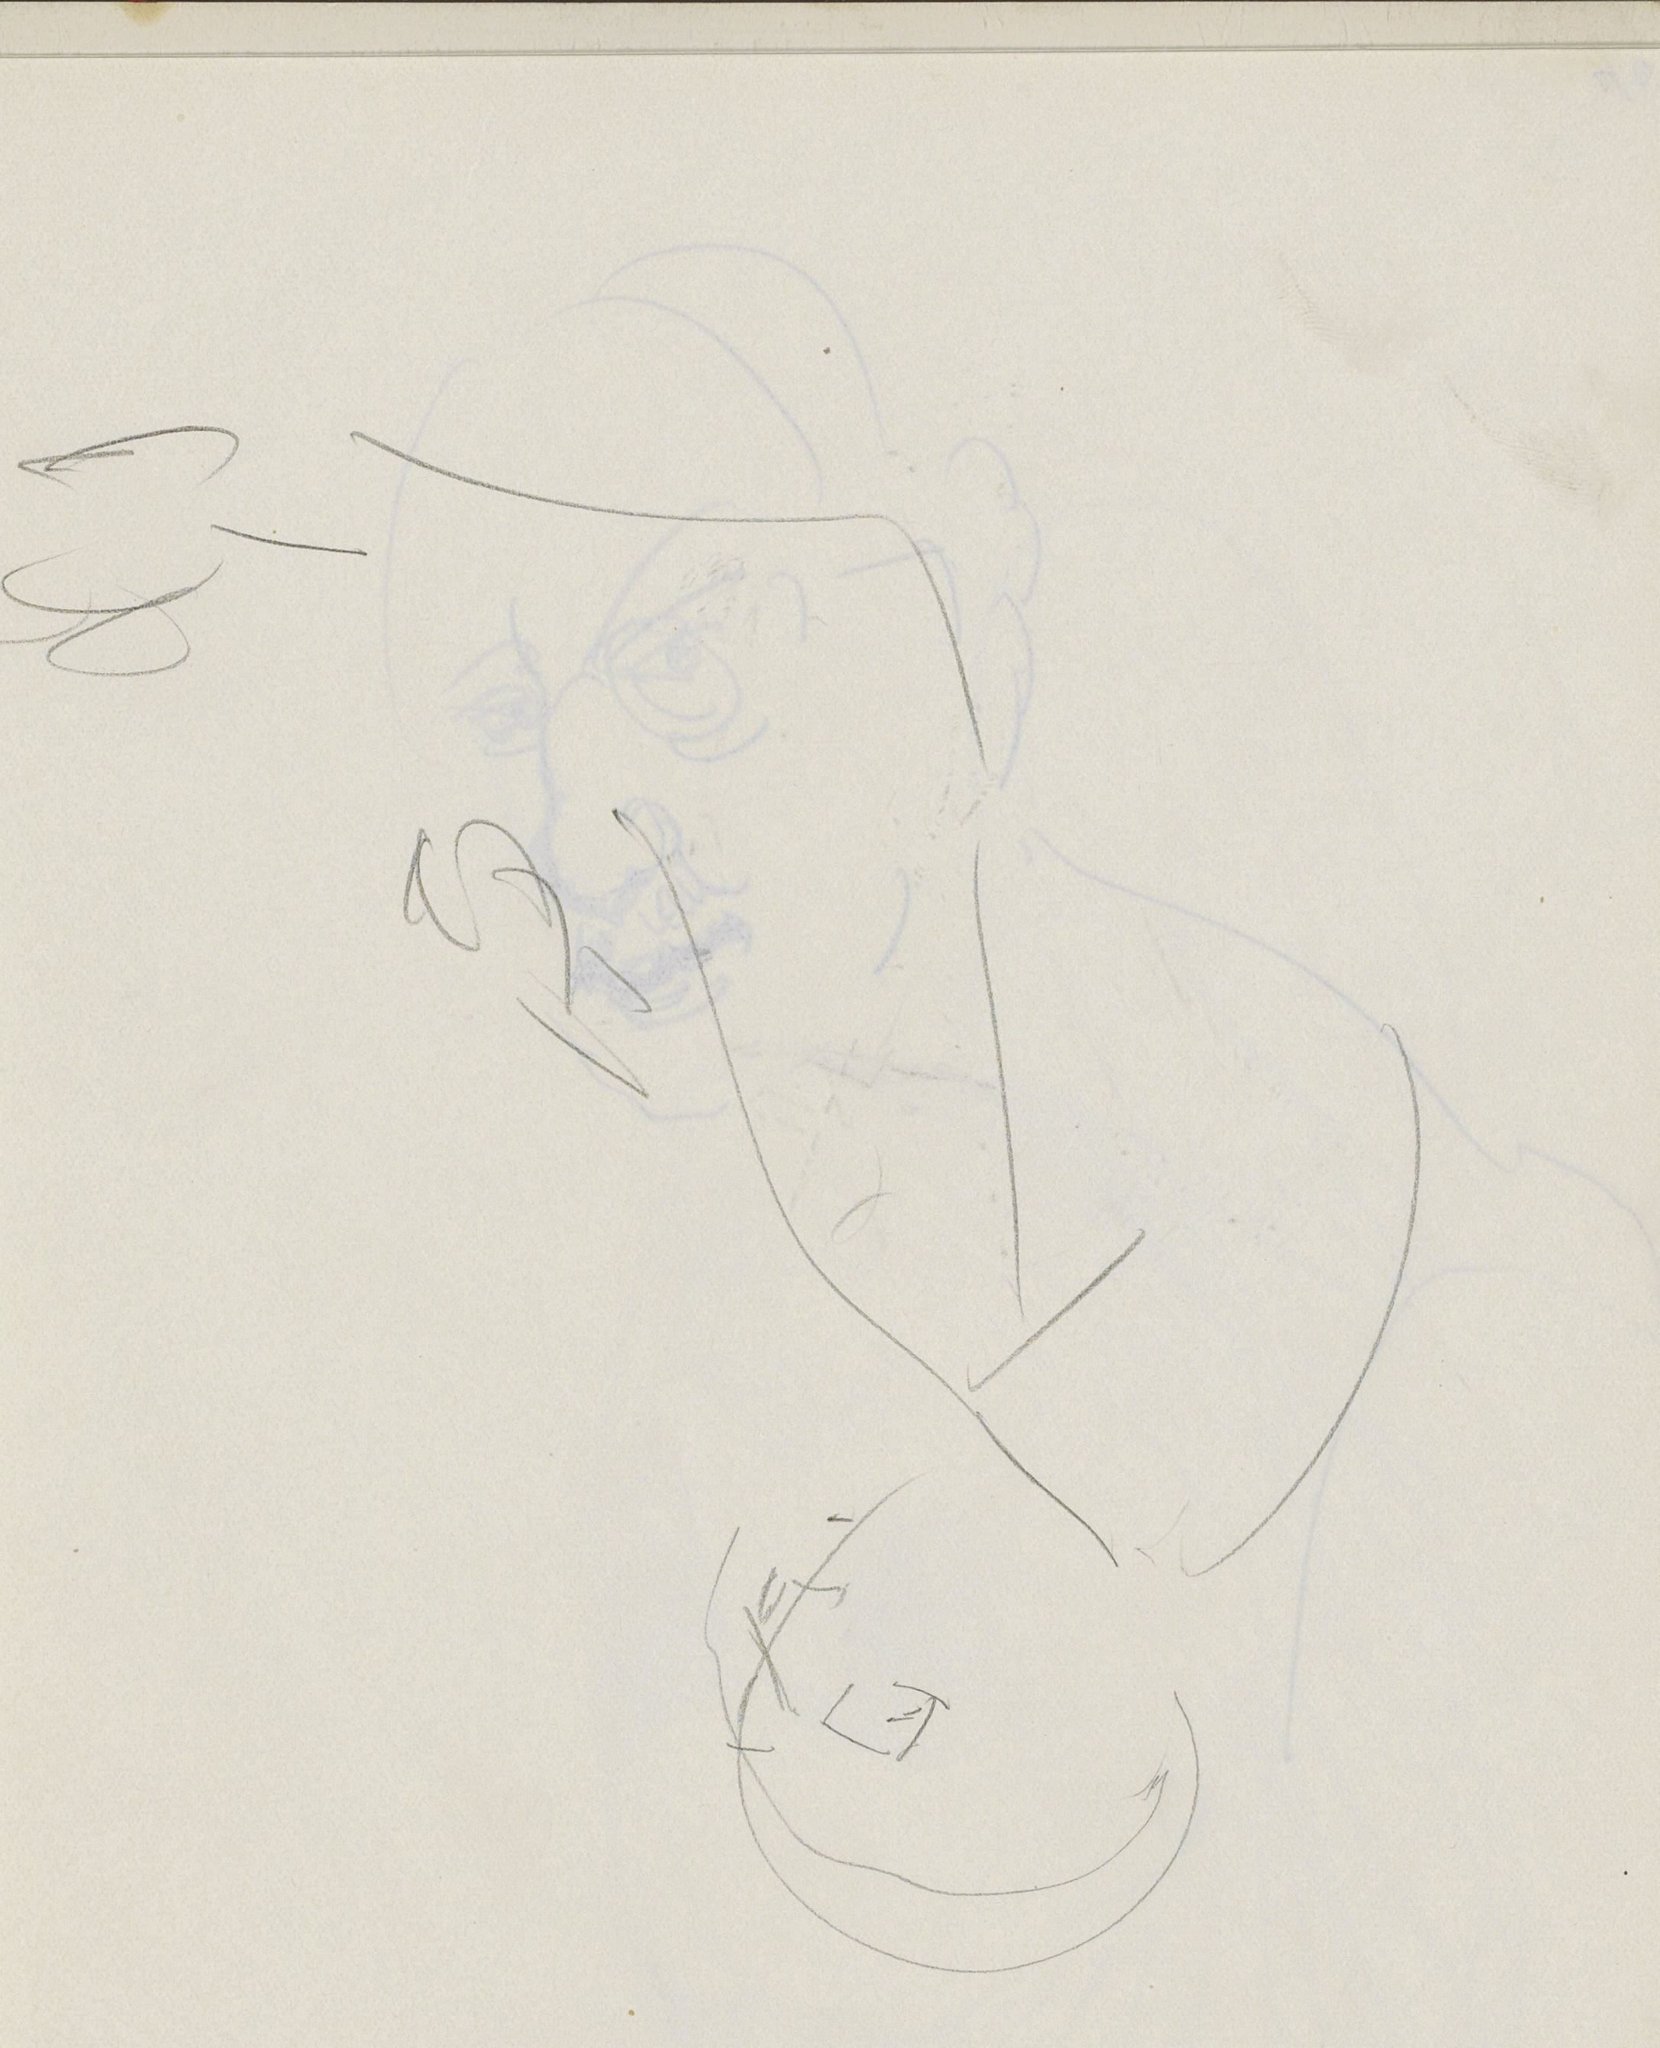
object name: sketchbook leaf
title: Zittende man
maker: isaac israels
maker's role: draughtsman, painter, print maker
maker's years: 1865-1934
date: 1925-1934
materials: paper, pencil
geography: the hague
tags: adult man (+ sitting)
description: Blad 31 recto uit schetsboek XXVI met 35 bladen.